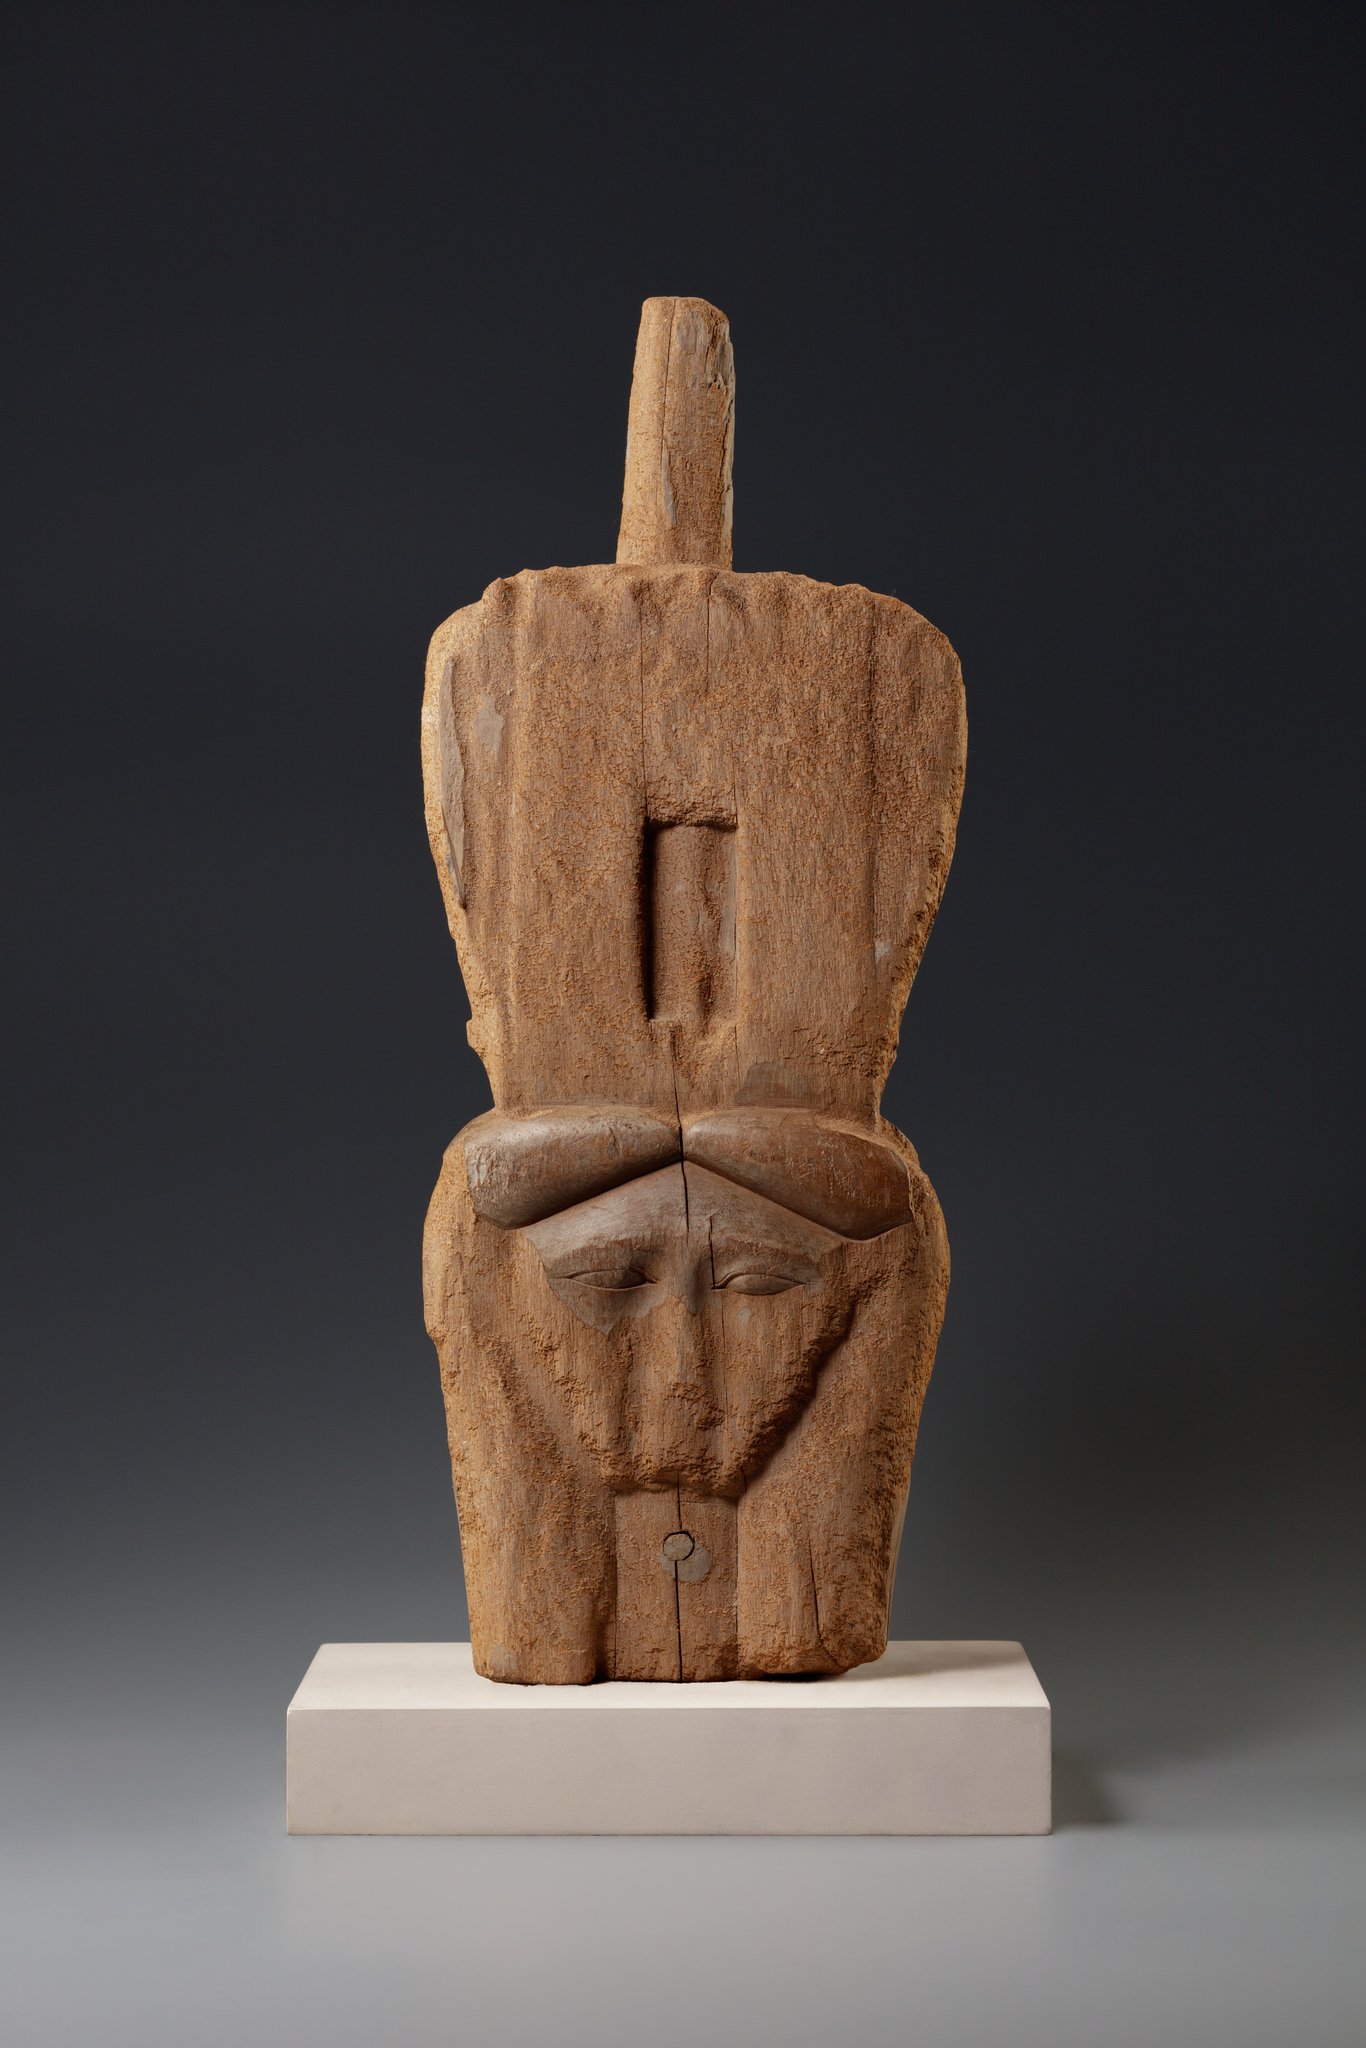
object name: music, sistrum, hathor emblem, bat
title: Wooden Hathor column for a shrine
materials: wood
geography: egypt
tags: hathor